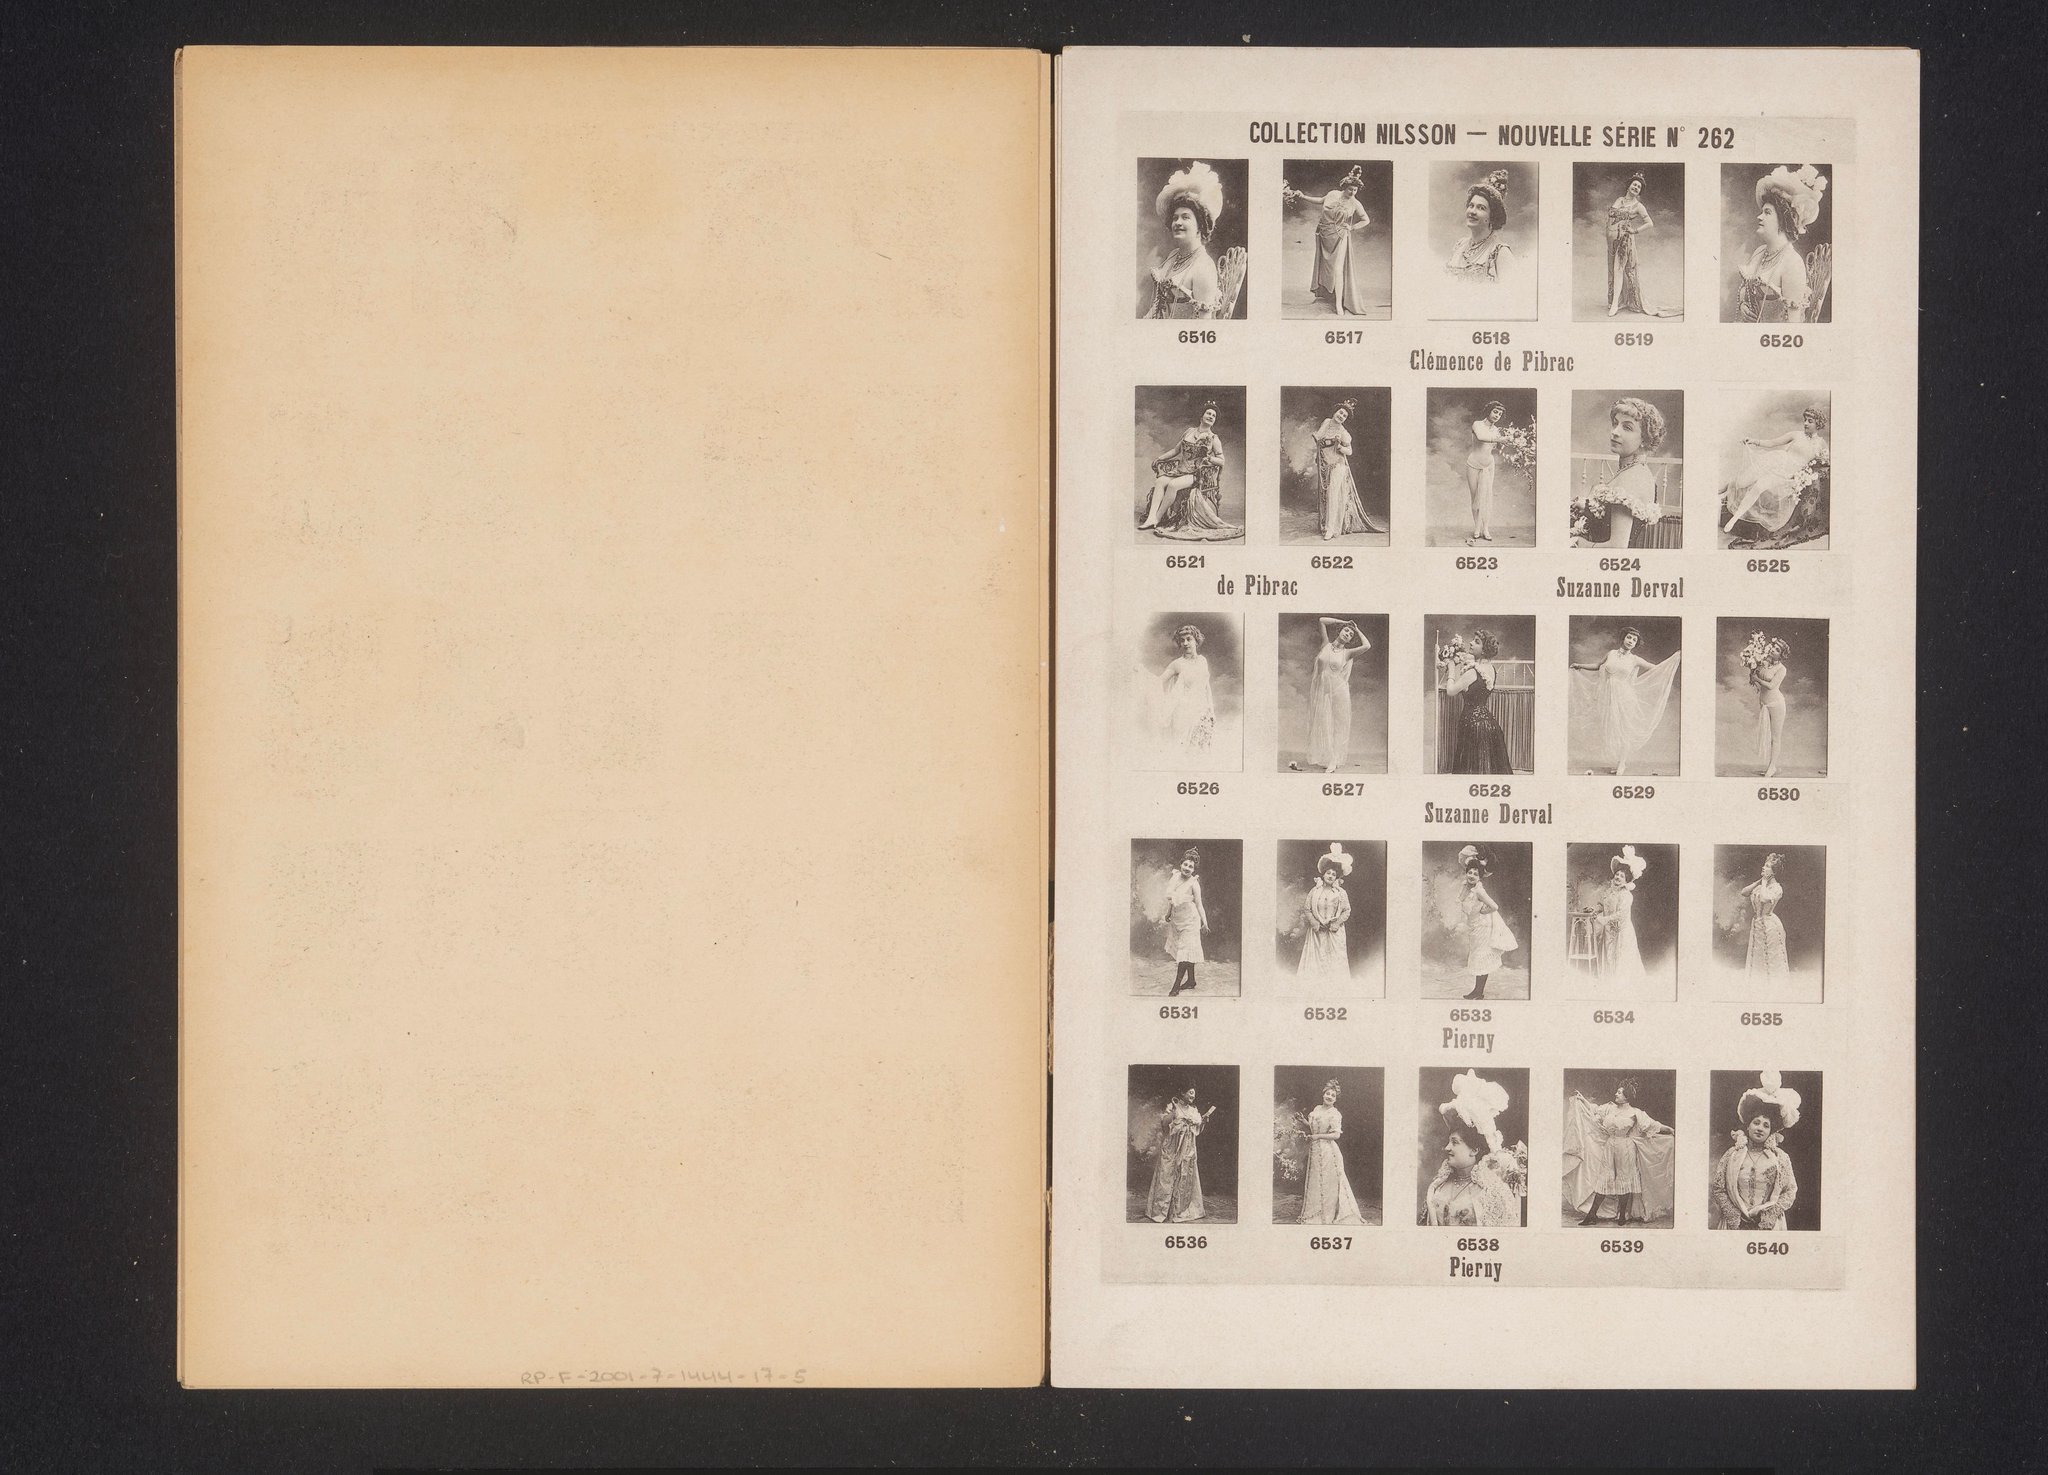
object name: photomechanical print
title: 25 portretten van Clémence de Pibrac, Suzanne Derval en Pierny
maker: Anonymous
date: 1894-1899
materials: paper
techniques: photograph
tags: historical persons - bb - woman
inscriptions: number: ‘No 262’